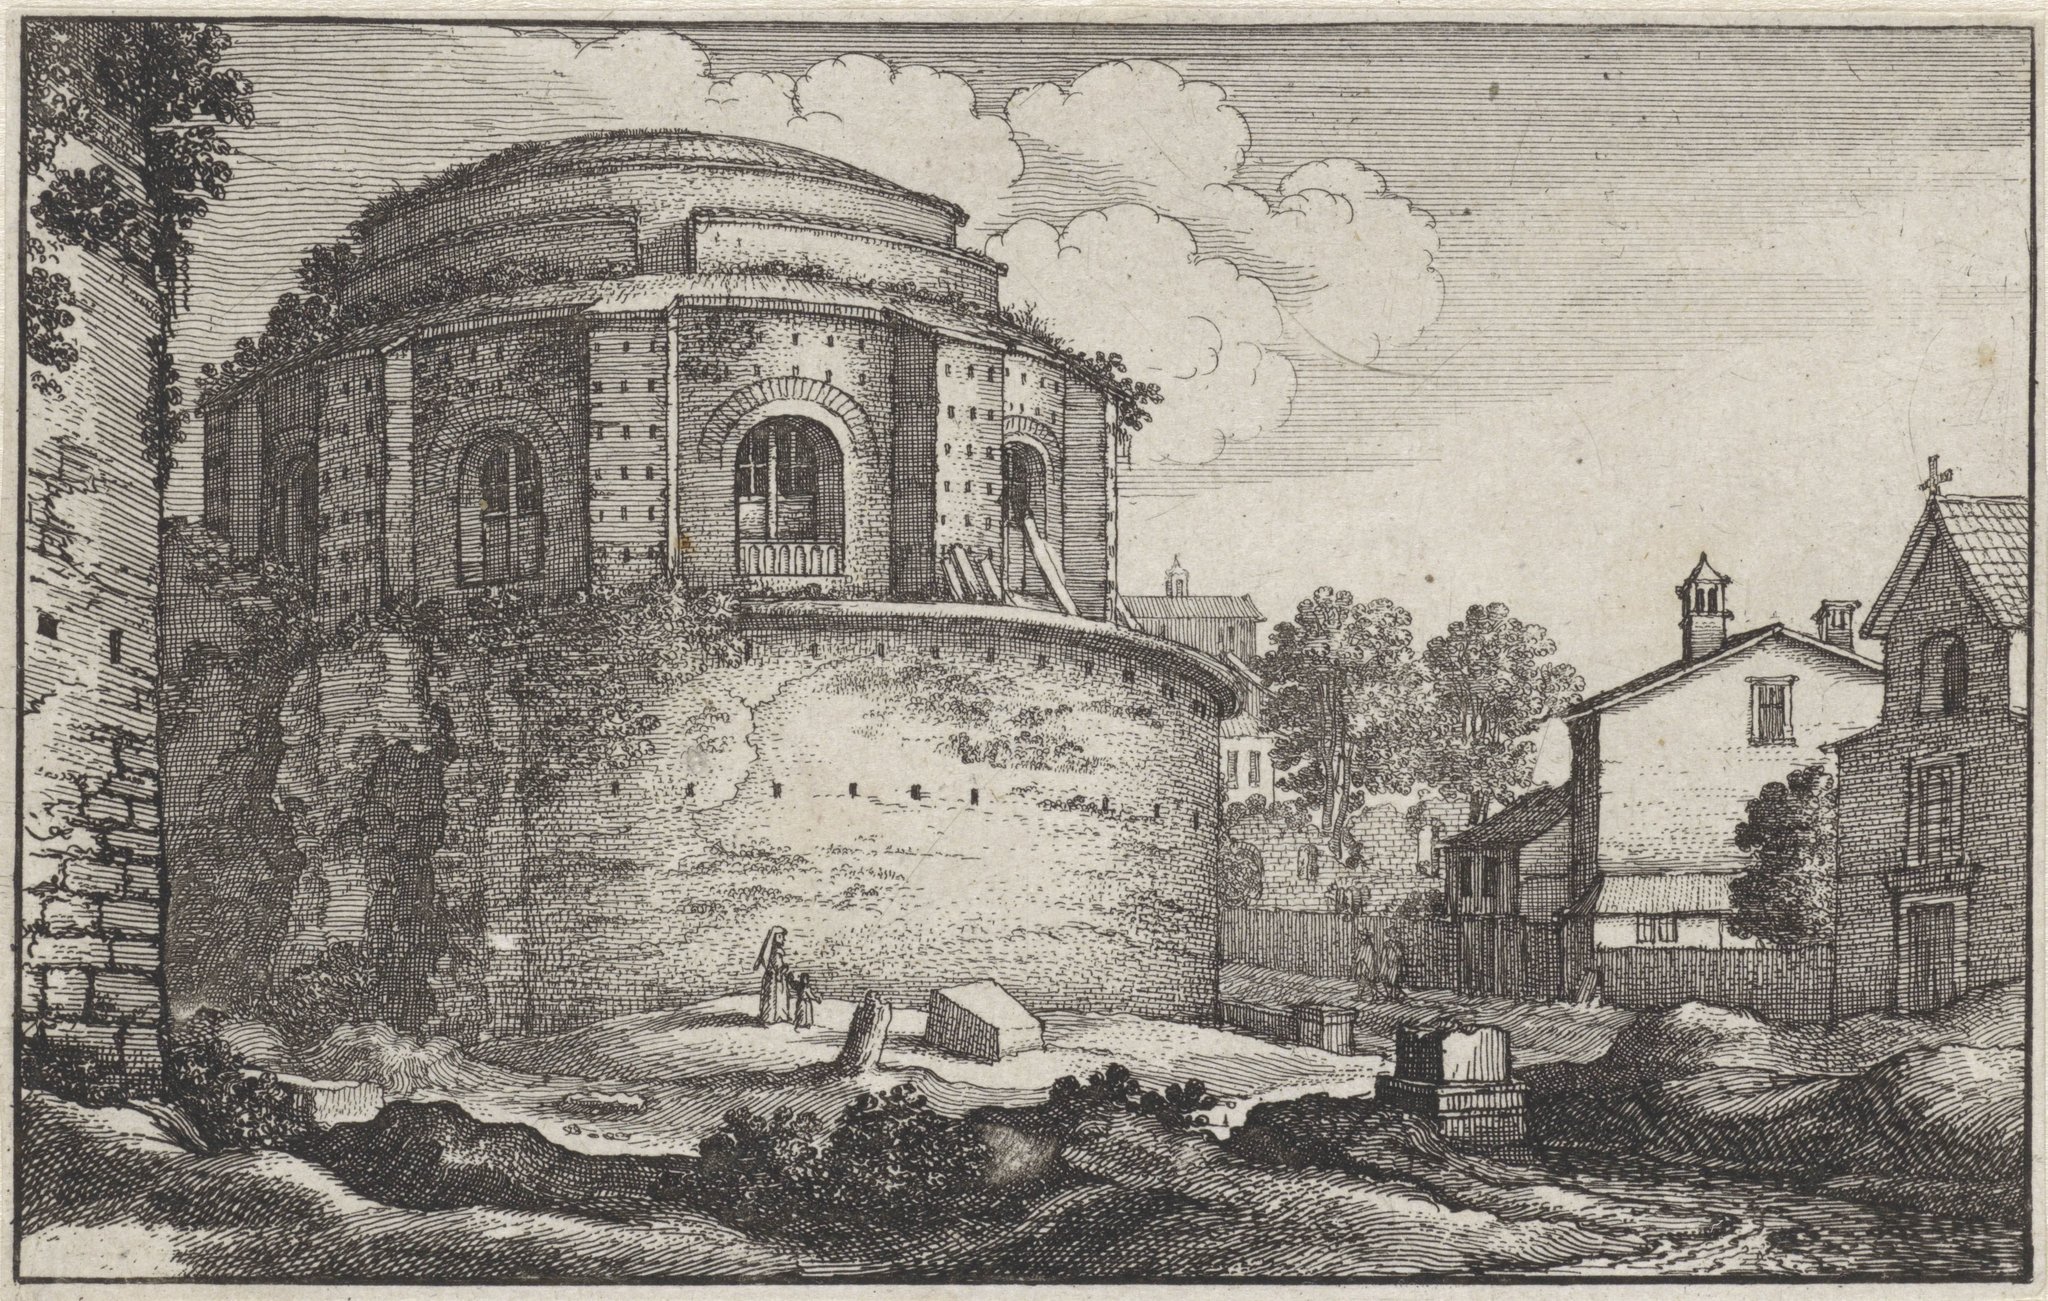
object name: print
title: Gezicht op een rond Romeins gebouw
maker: wenceslaus hollar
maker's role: draughtsman, print maker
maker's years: 1607-1677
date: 1673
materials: paper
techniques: etching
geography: london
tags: landscape with ruins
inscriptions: collector's mark: Lugt 2760, collector's mark: Lugt 2228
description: De prent maakt deel uit van een tweedelige serie met voorstellingen van Romeinse ruïnes.